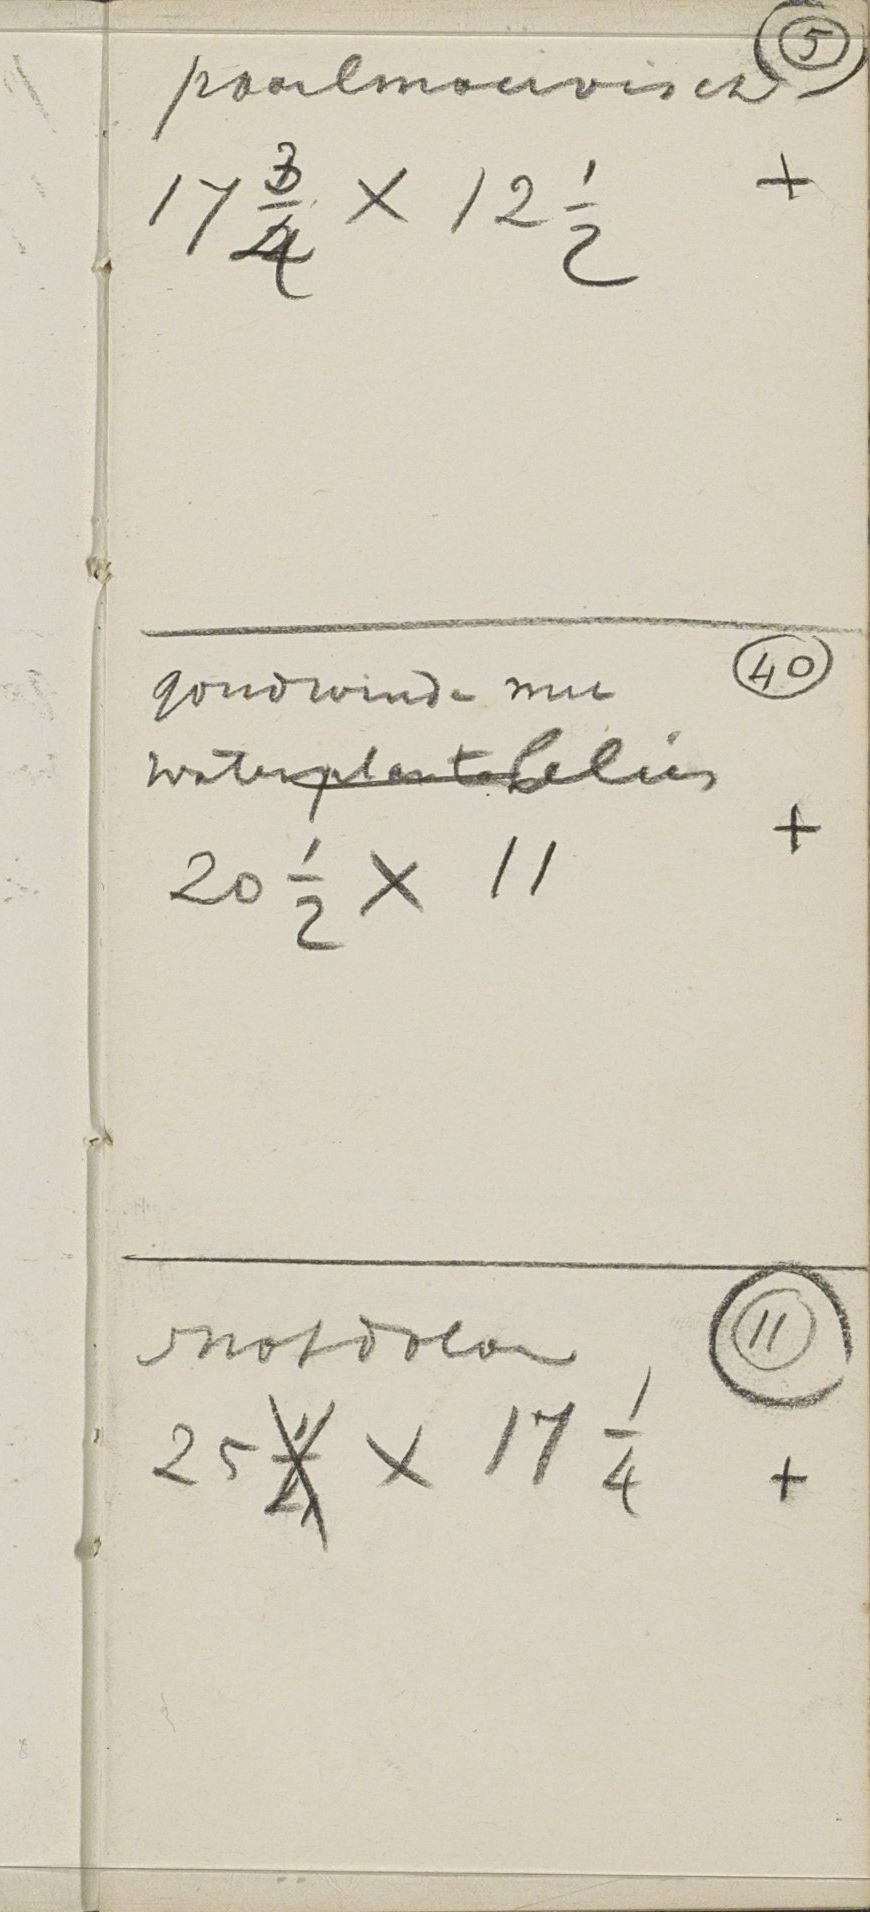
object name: sketchbook leaf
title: Notities over kunstwerken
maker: gerrit willem dijsselhof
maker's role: designer, draughtsman, print maker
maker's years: 1866-1924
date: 1876-1924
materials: chalk, paper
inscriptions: annotation: ‘paarlmoervisch 5/ [...]’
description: Blad 3 recto uit een schetsboek met 40 bladen.